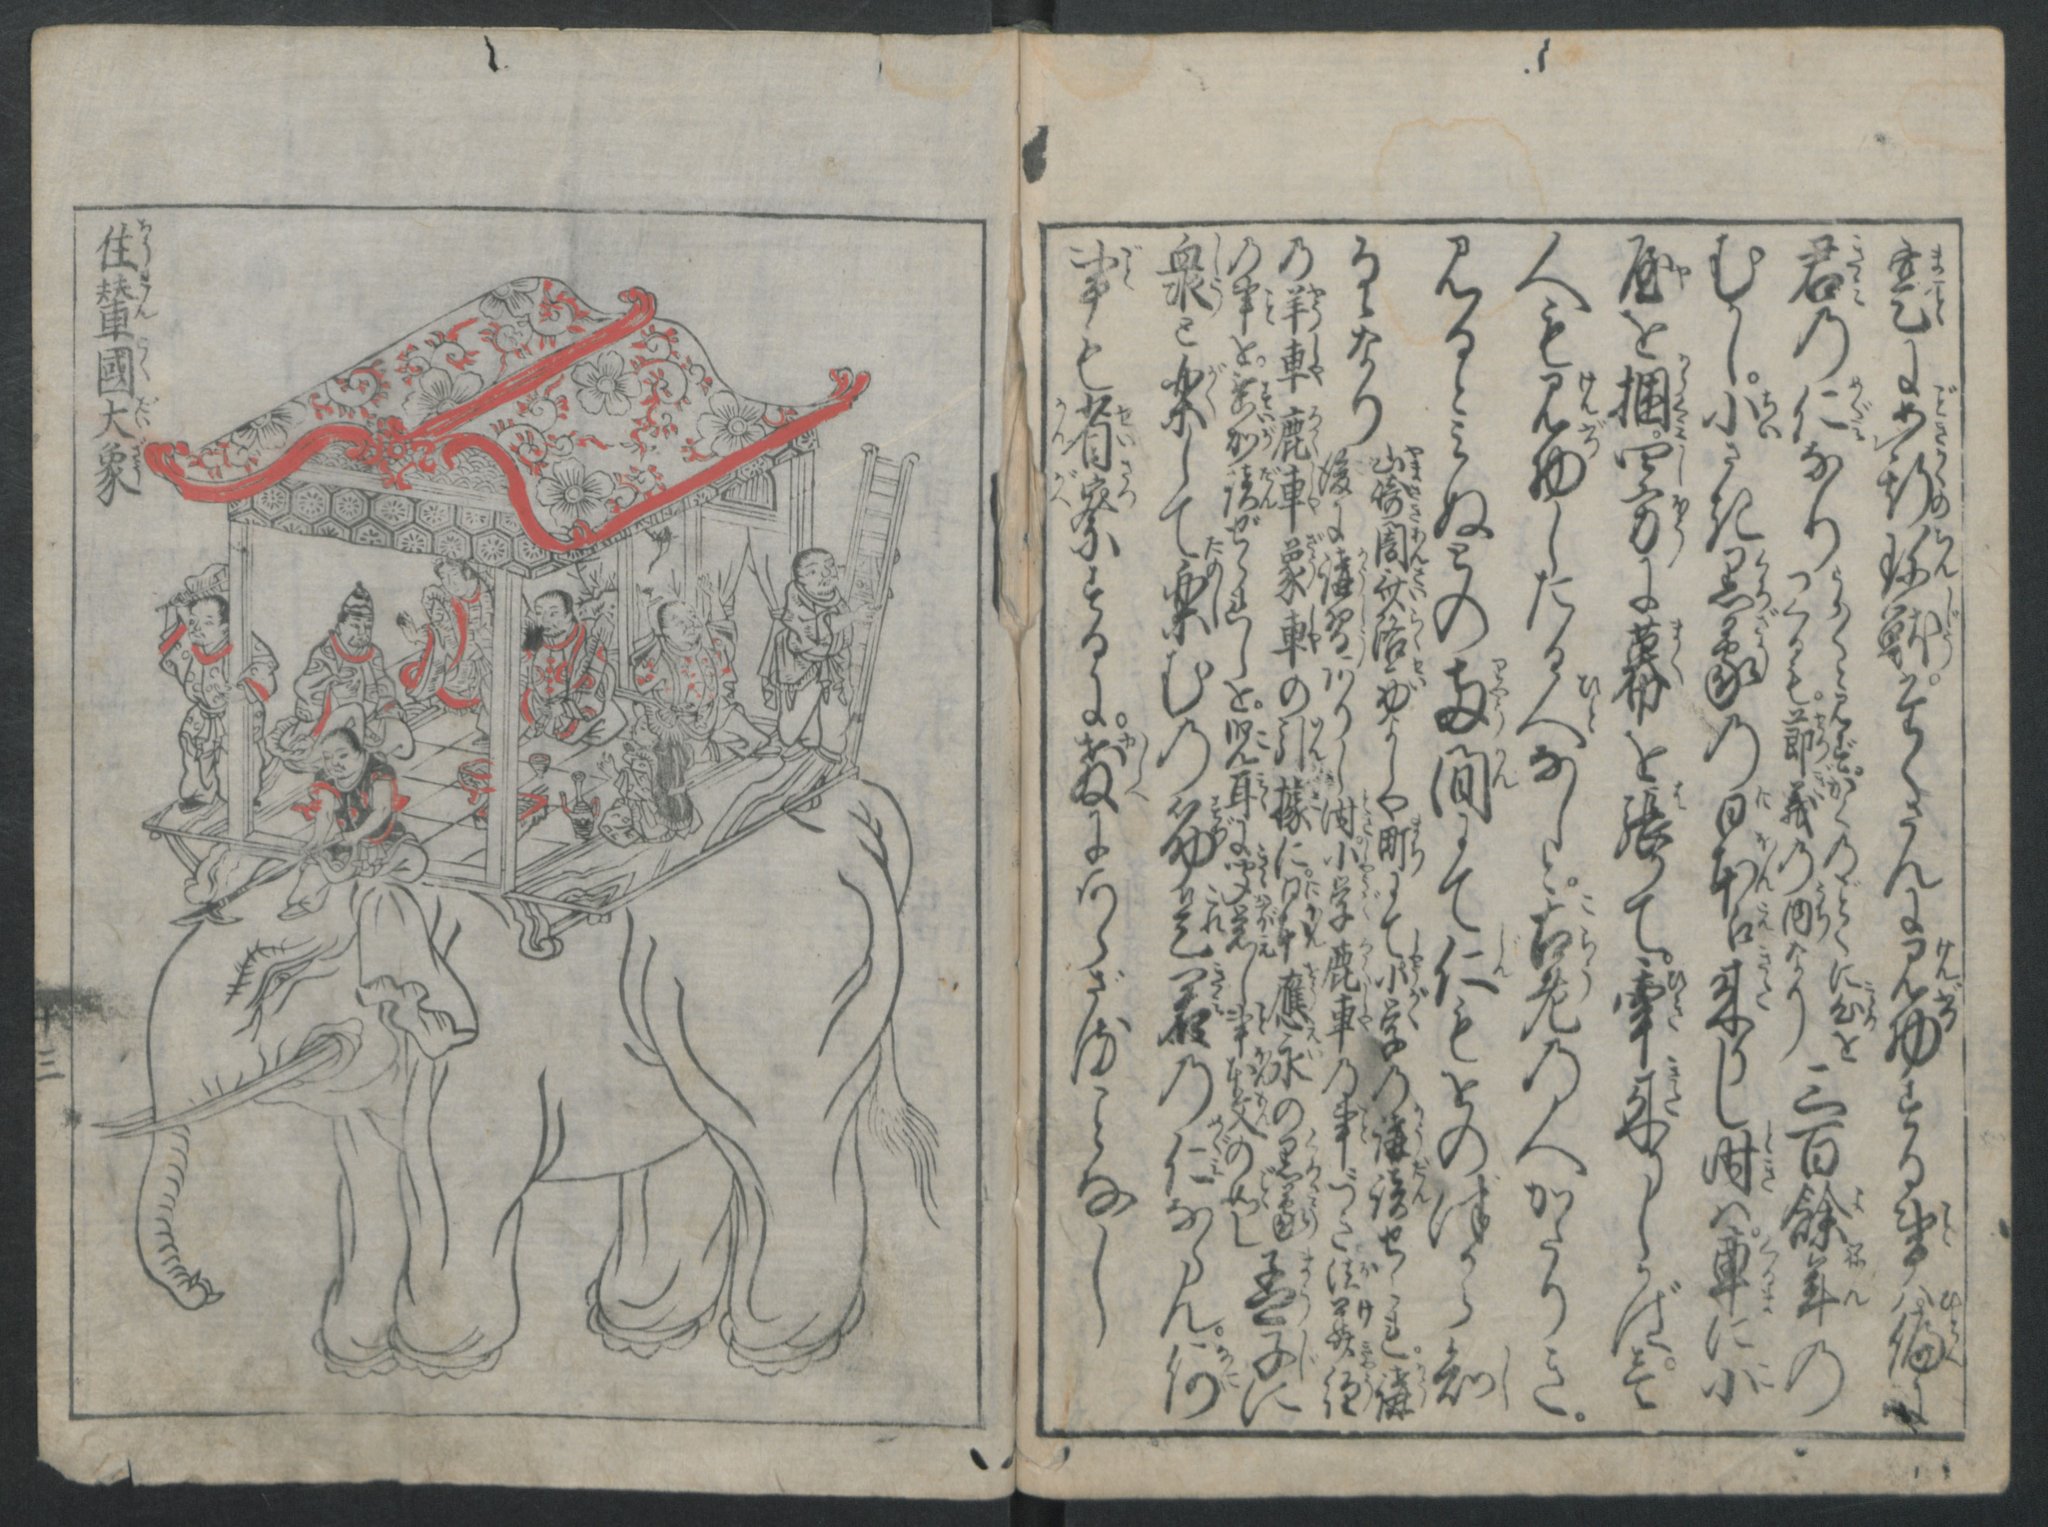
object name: illustrated book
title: The Tribute Elephants (Zō no mitsugi) 象のみつぎ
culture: japanese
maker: nakamura heigo 中村平五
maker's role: artist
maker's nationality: japanese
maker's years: 1671-1741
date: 1729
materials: ink, paper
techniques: woodblock print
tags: human figures,elephants